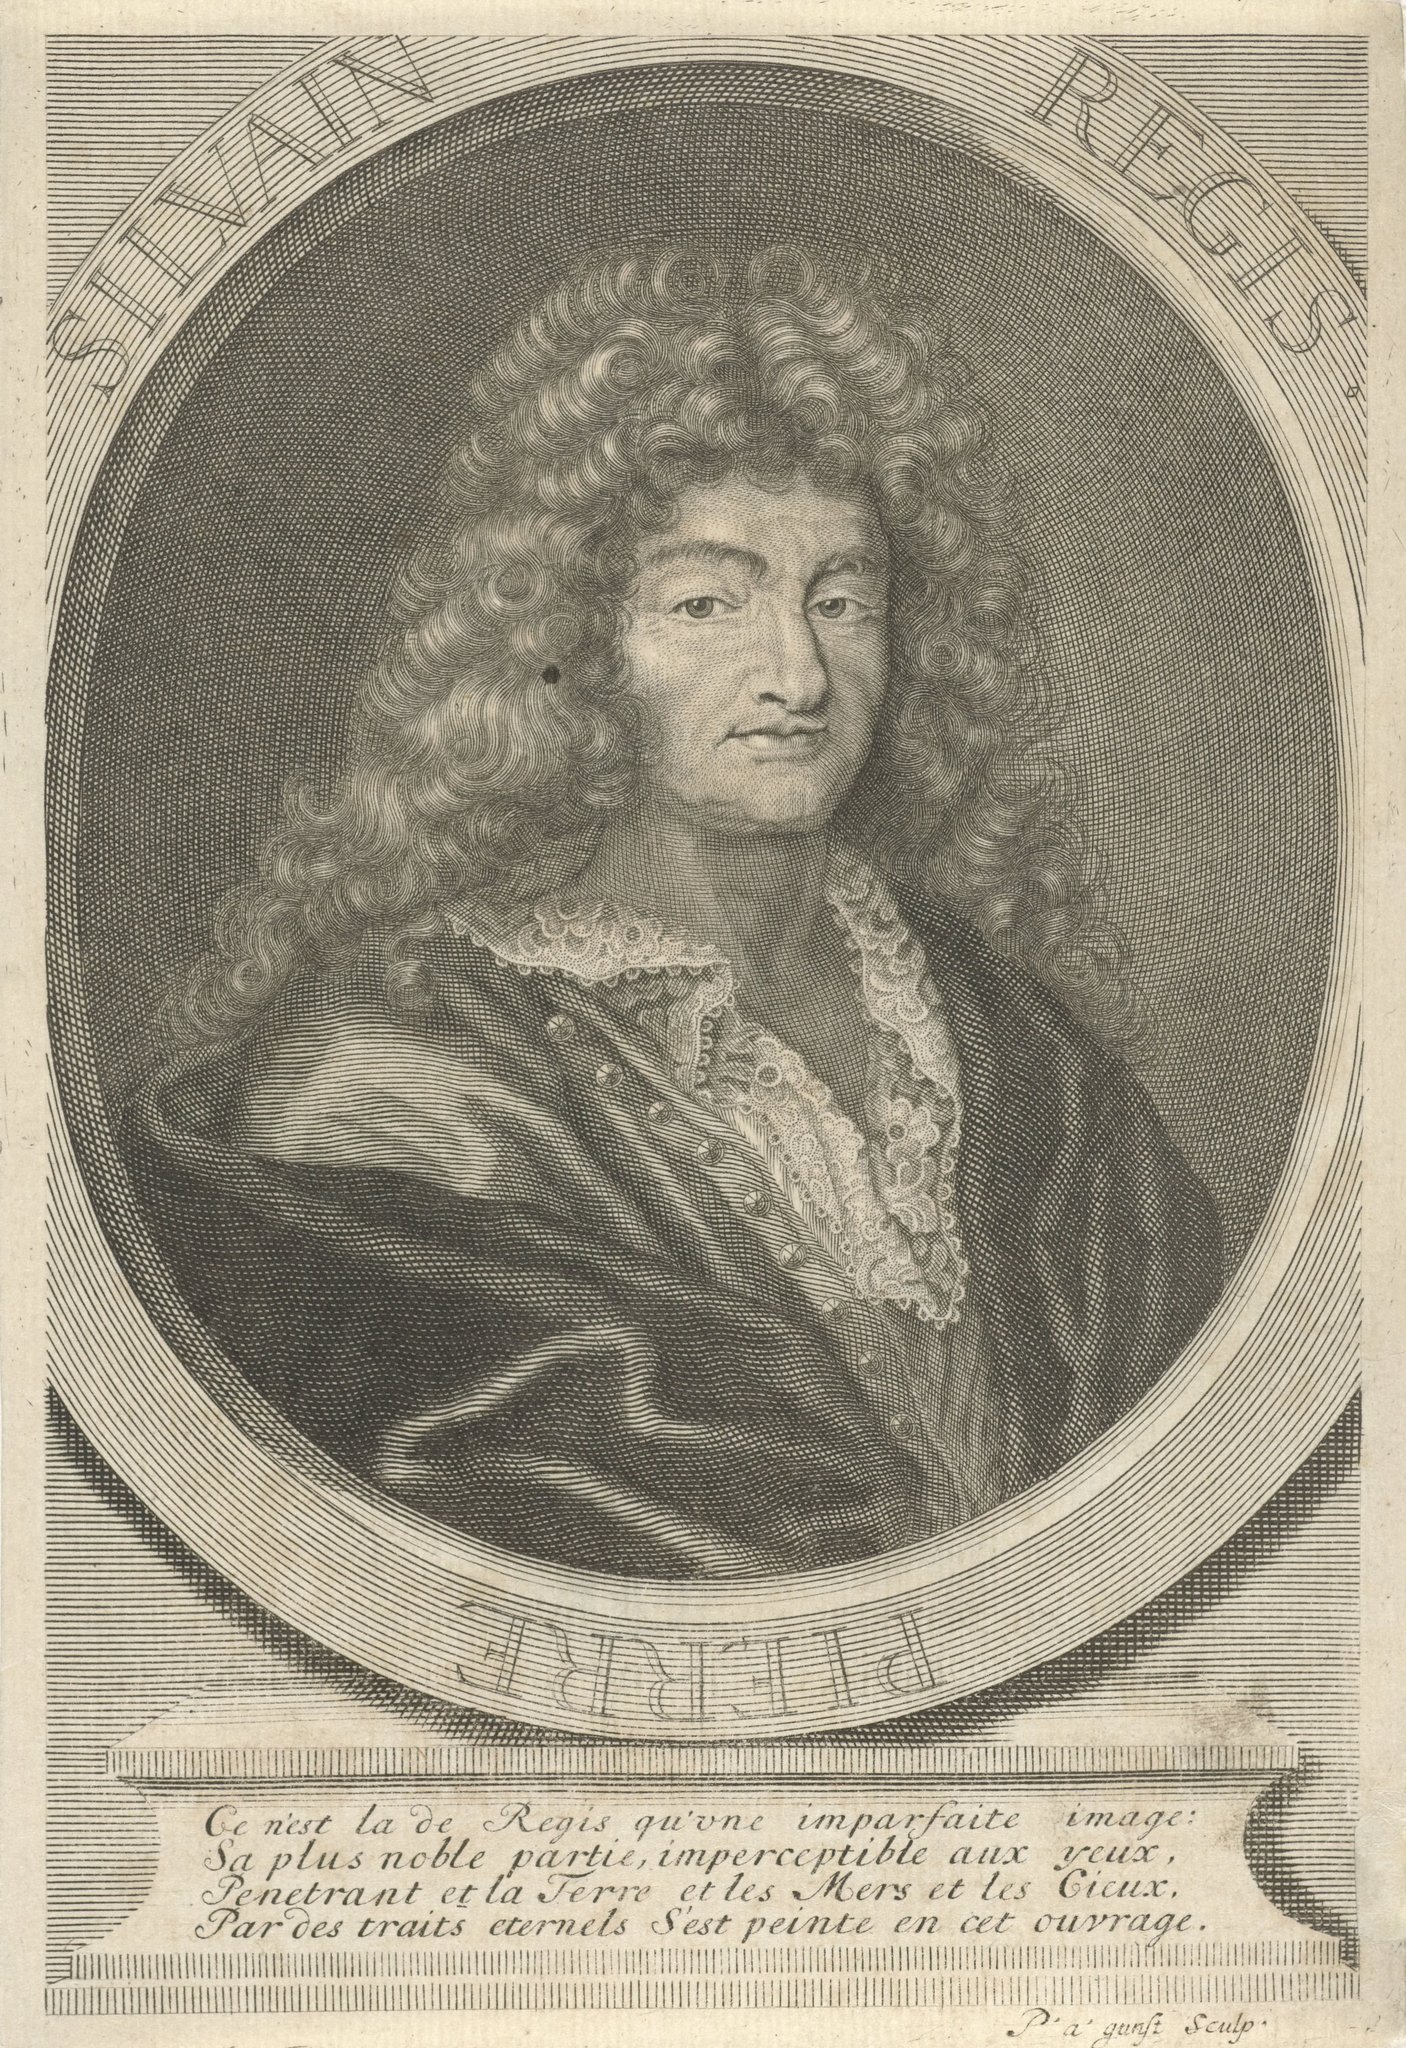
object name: print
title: Portret van Pierre-Silvain Régis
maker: pieter van gunst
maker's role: print maker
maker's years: 1658-1731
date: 1659-1731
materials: paper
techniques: engraving, etching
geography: amsterdam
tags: paris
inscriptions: collector's mark: Lugt 2228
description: Pierre-Silvain Régis, een Frans filosoof. De prent heeft Frans onderschrift over zijn filosofie.